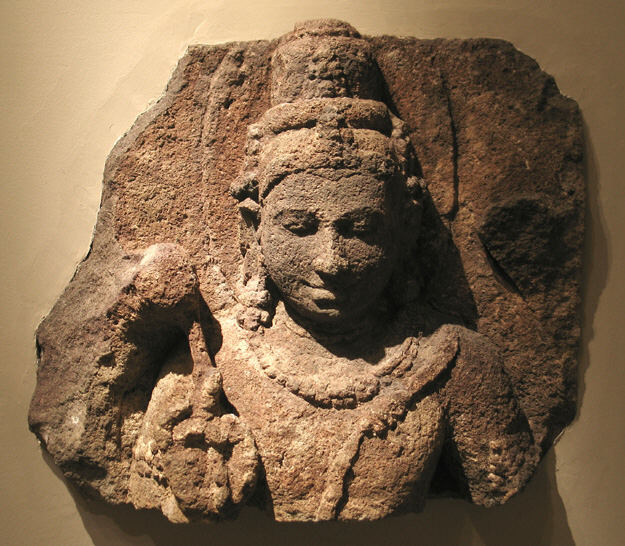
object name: bust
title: Torso of a Bodhisattva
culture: indonesian, javanese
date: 801-900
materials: stone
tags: buddhism,bodhisattvas